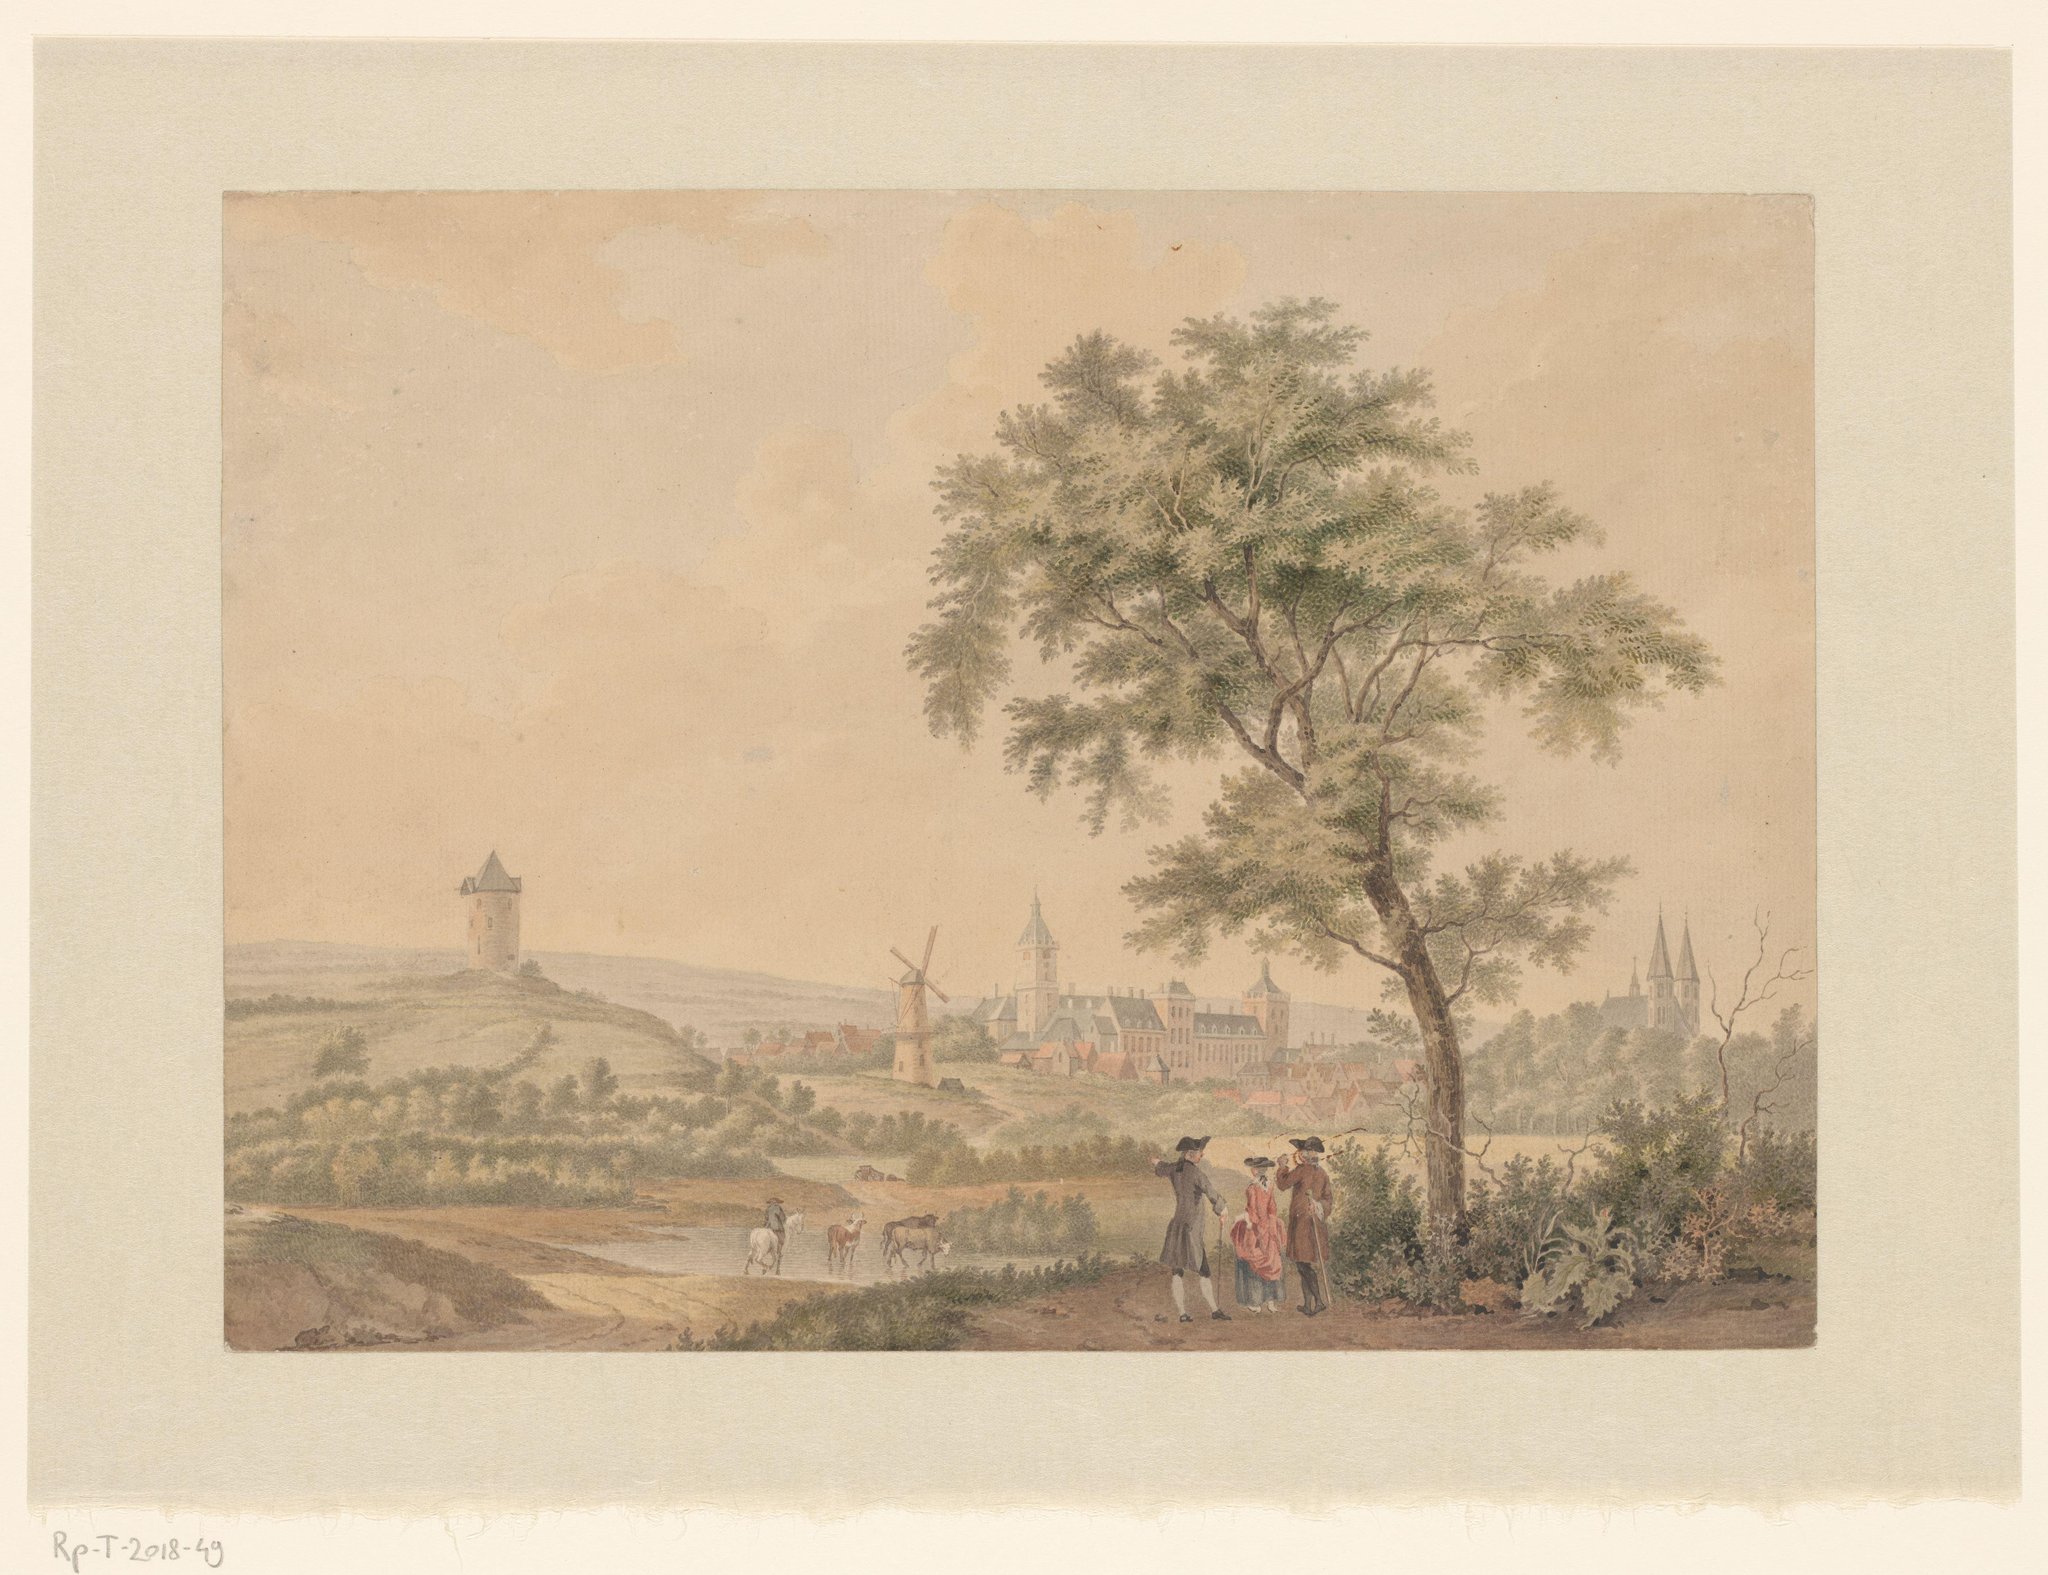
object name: drawing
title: Gezicht op Kleef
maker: Anonymous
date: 1700-1799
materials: paper, watercolor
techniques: brush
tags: prospect of city, town panorama, silhouette of city (+ city(-scape) with figures, staffage), cleves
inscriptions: collector's mark: Lugt 2228